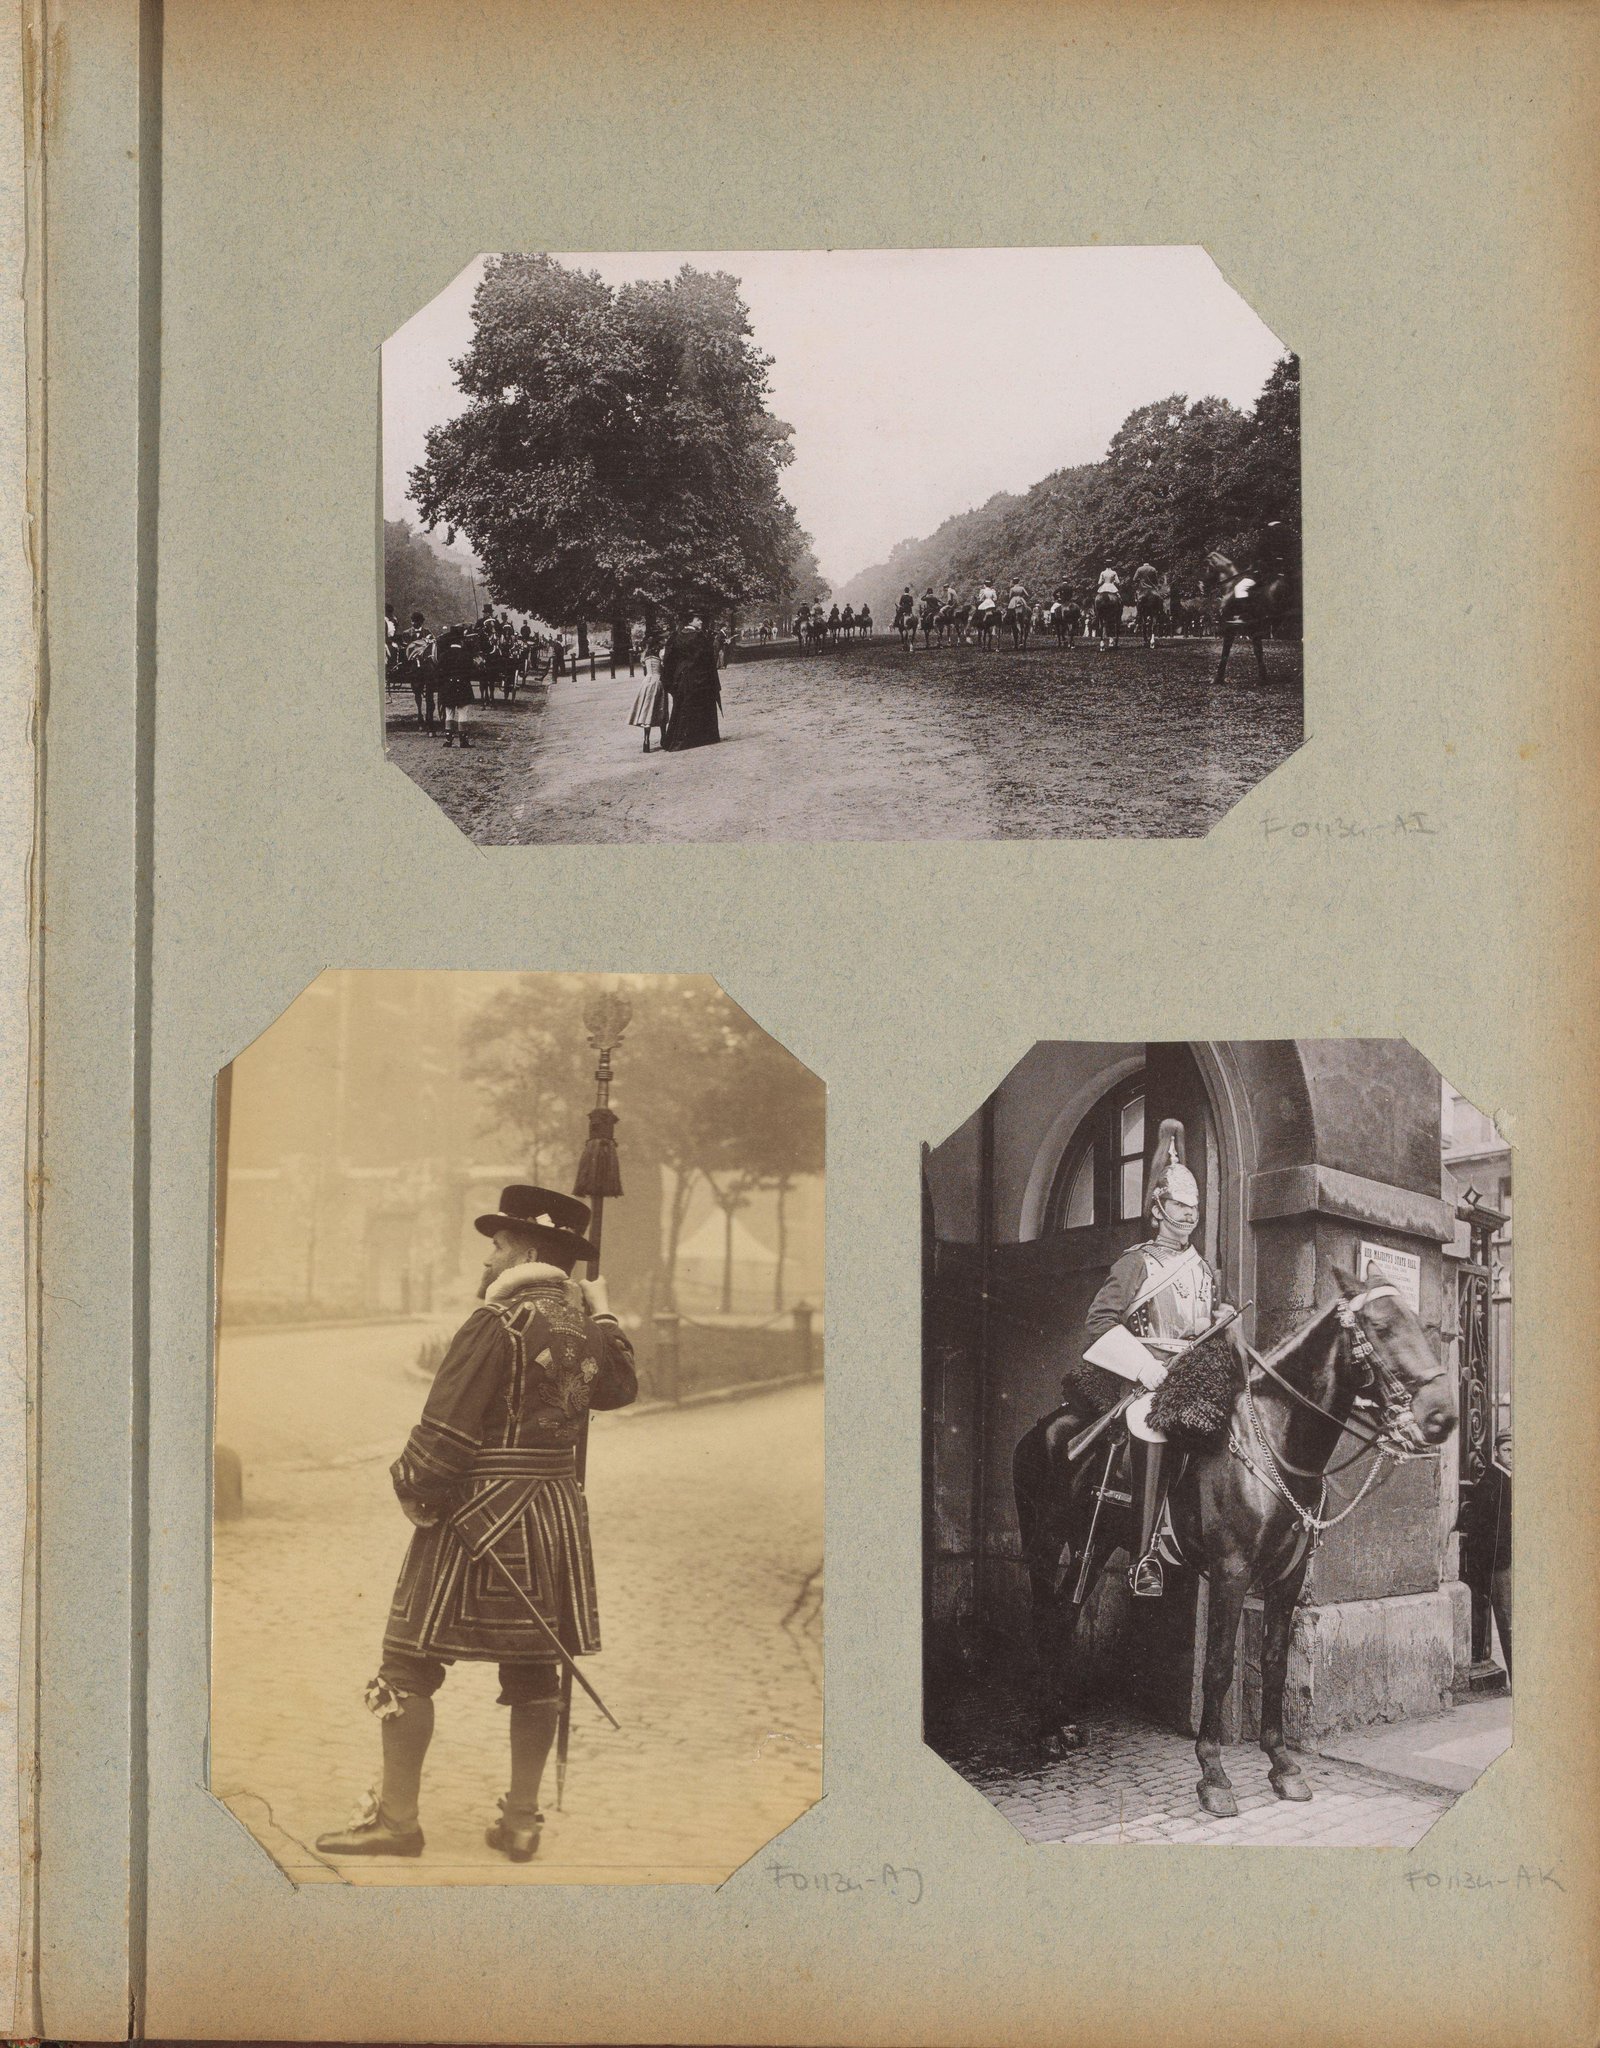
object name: album leaf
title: Portret van een Yeomen Warder (Beefeater) in Londen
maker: Anonymous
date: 1880-1910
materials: paper, photographic support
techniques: albumen print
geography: london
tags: (military) uniforms, prison personnel: jailers, warders, guards, london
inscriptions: inscription: ‘Tower Warder’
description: Onderdeel van Reisalbum met bezienswaardigheden in Engeland, Zwitserland, Frankrijk en Duitsland.